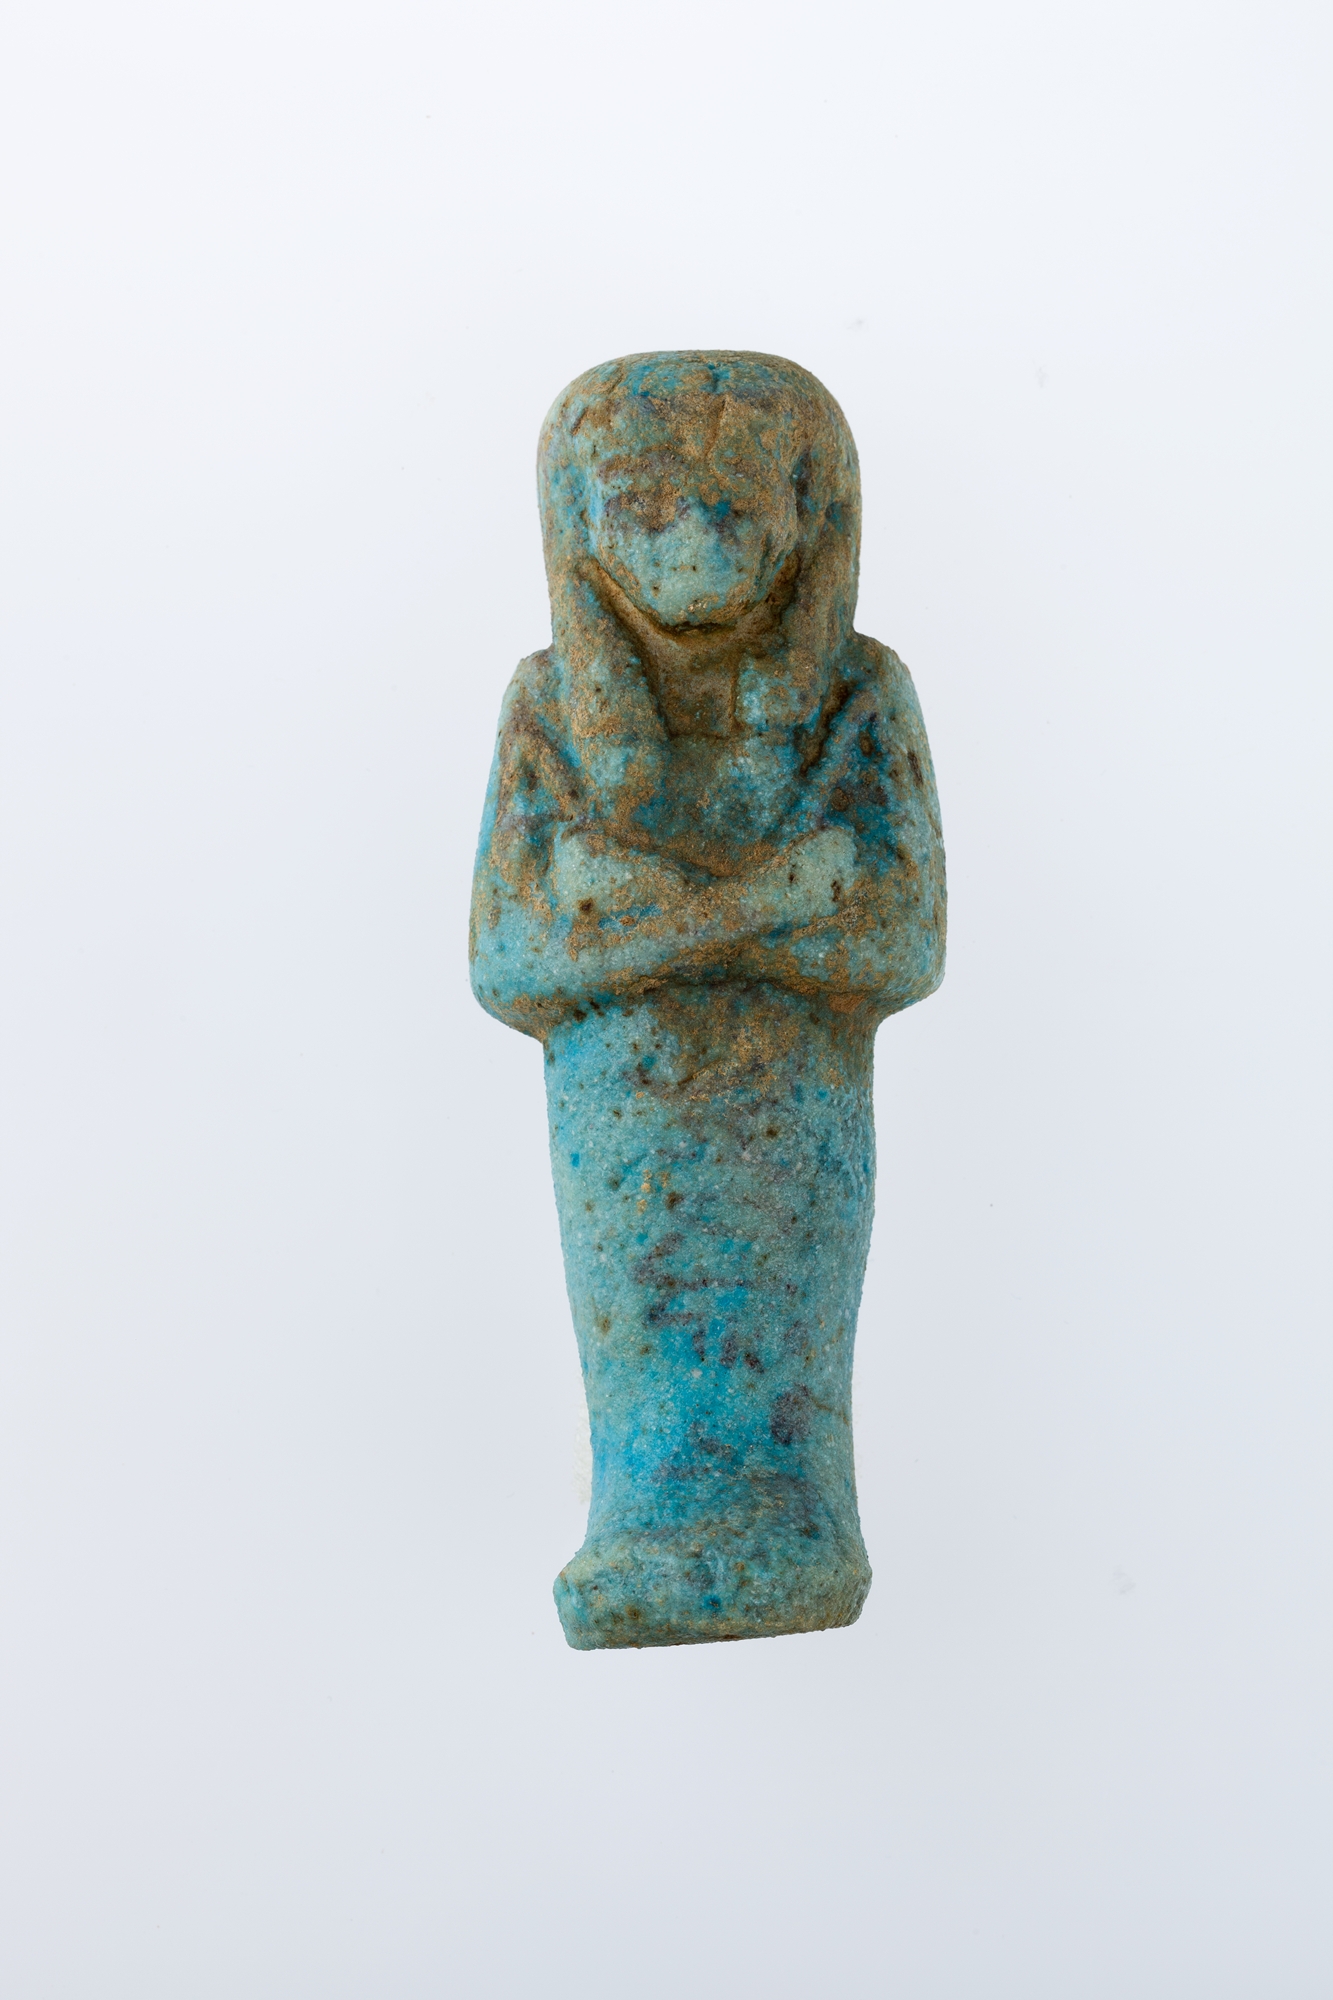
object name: shabti, henettawy c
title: Worker Shabti of Henettawy (C), Daughter of Isetemkheb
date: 990-970 BCE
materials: faience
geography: egypt